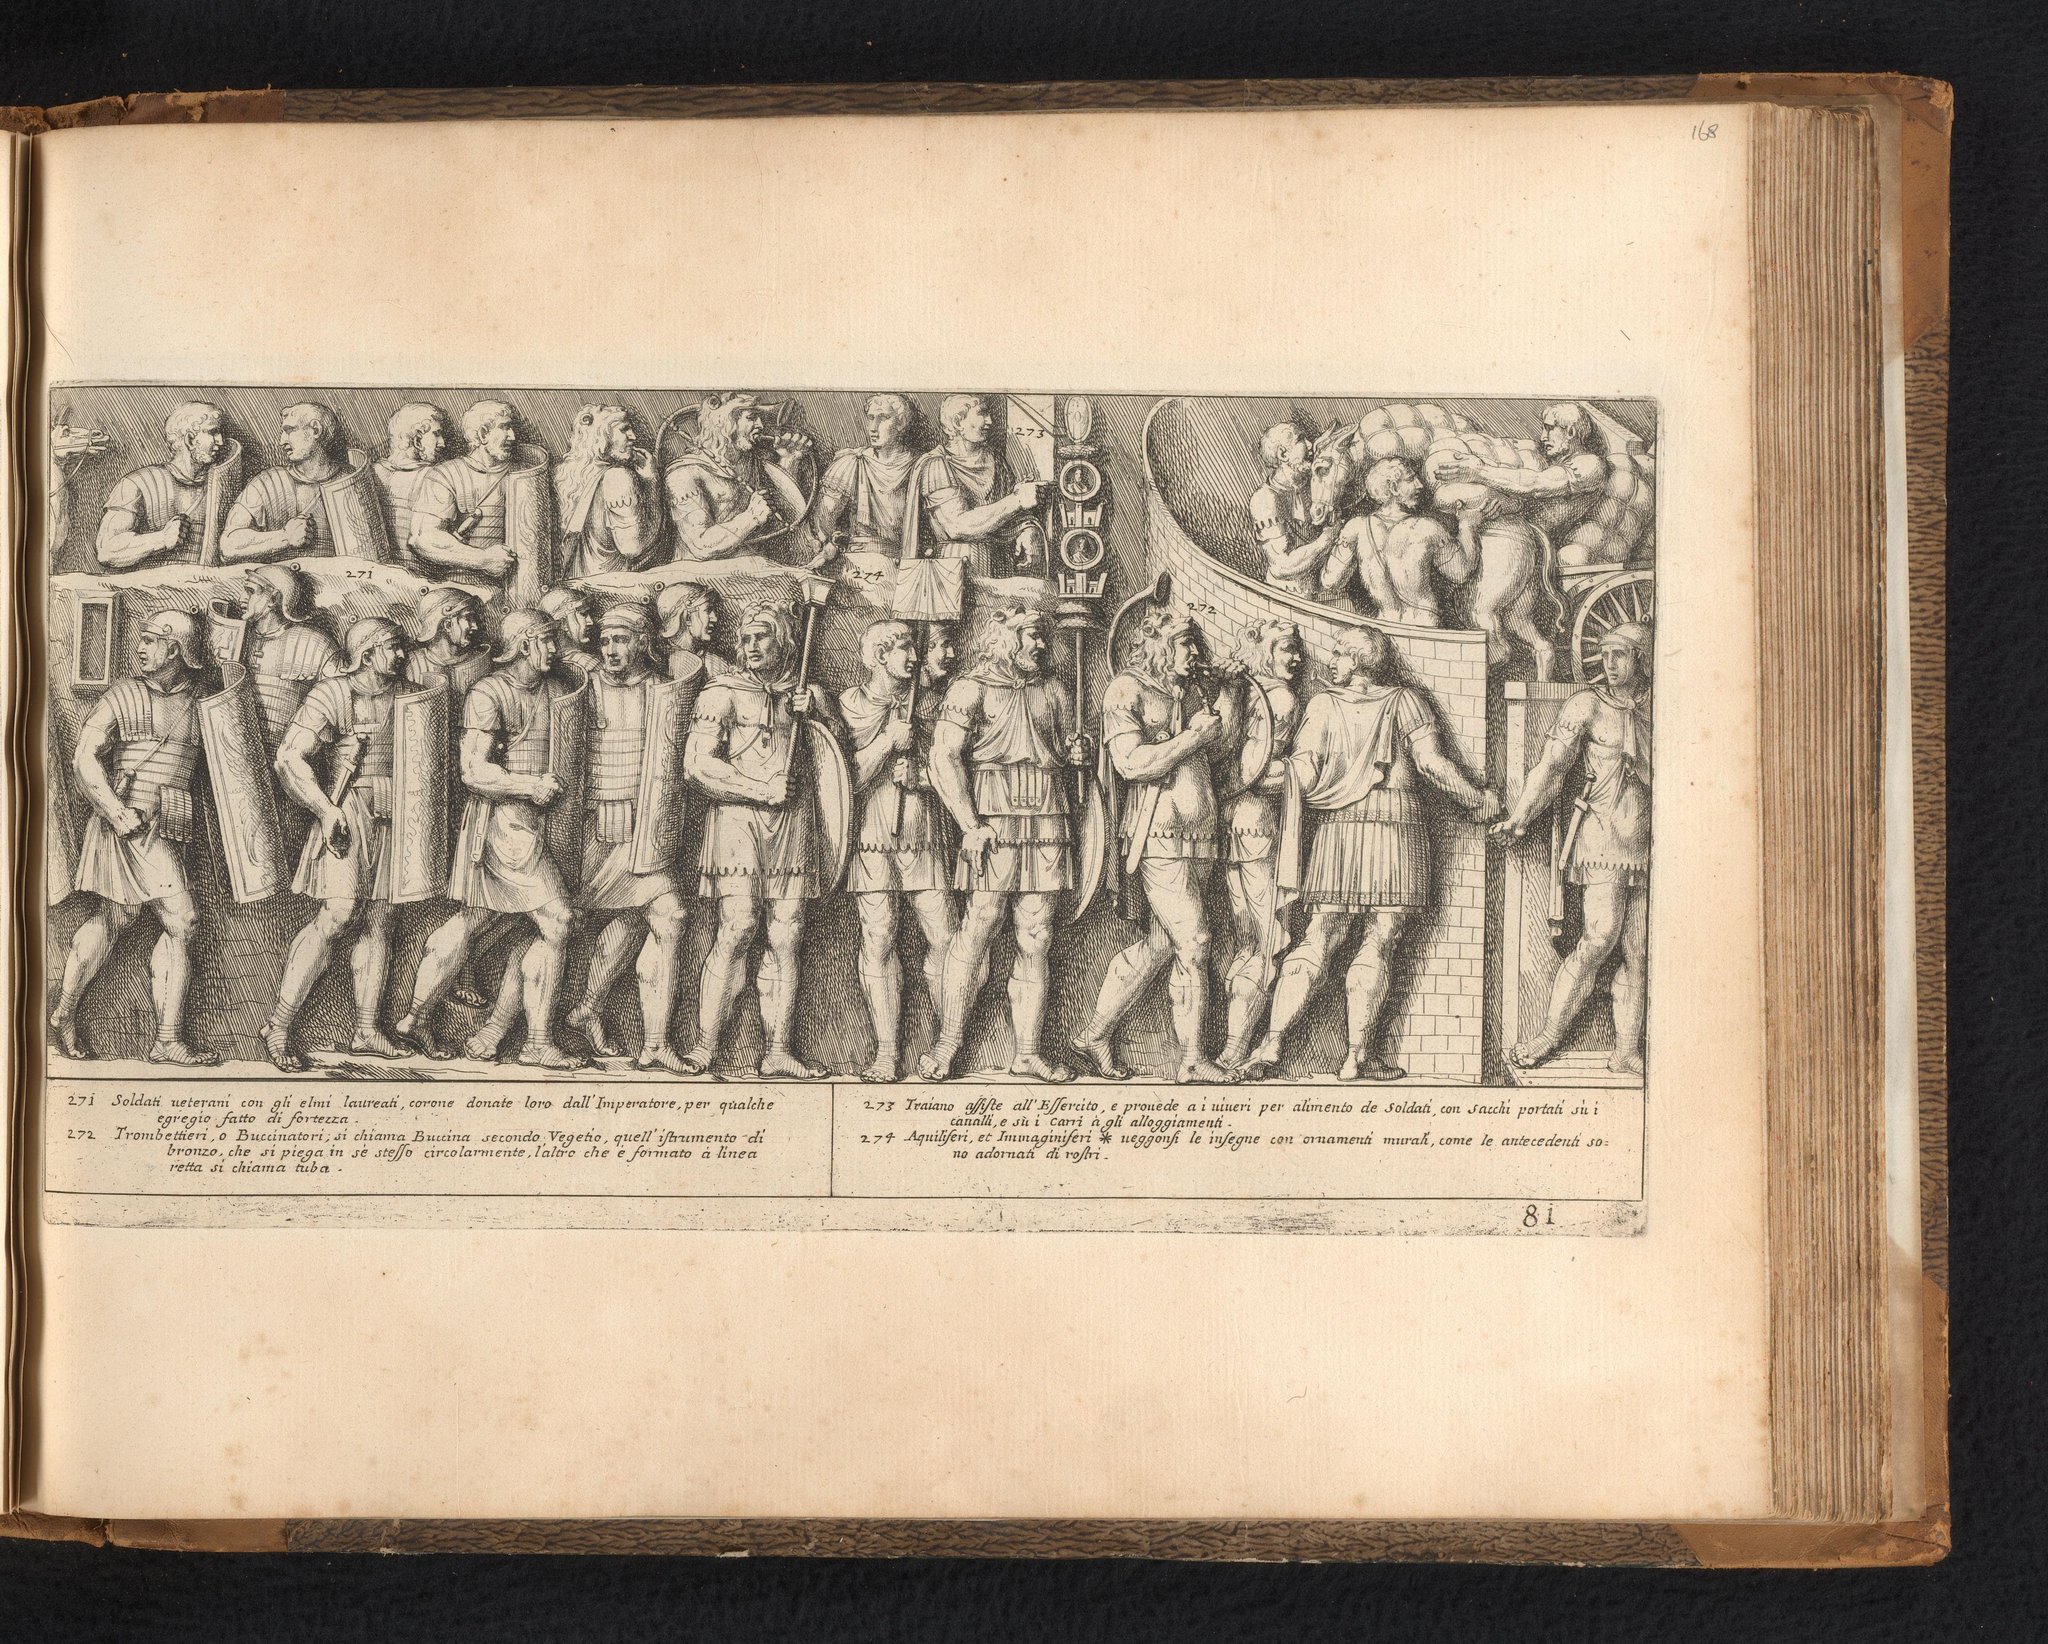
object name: print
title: Zuil van Trajanus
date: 1637-1691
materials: paper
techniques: etching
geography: vatican city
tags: triumphal column with helical friezes, piece of sculpture, reproduction of a piece of sculpture, the soldier; the soldier's life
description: Detail van het spiraalvormige gebeeldhouwde fries op de Zuil van Trajanus. Het fries toont de oorlogen tussen de Romeinen en de Daciërs. Verklarende nummers in de ondermarge. Prent maakt deel uit van een album.